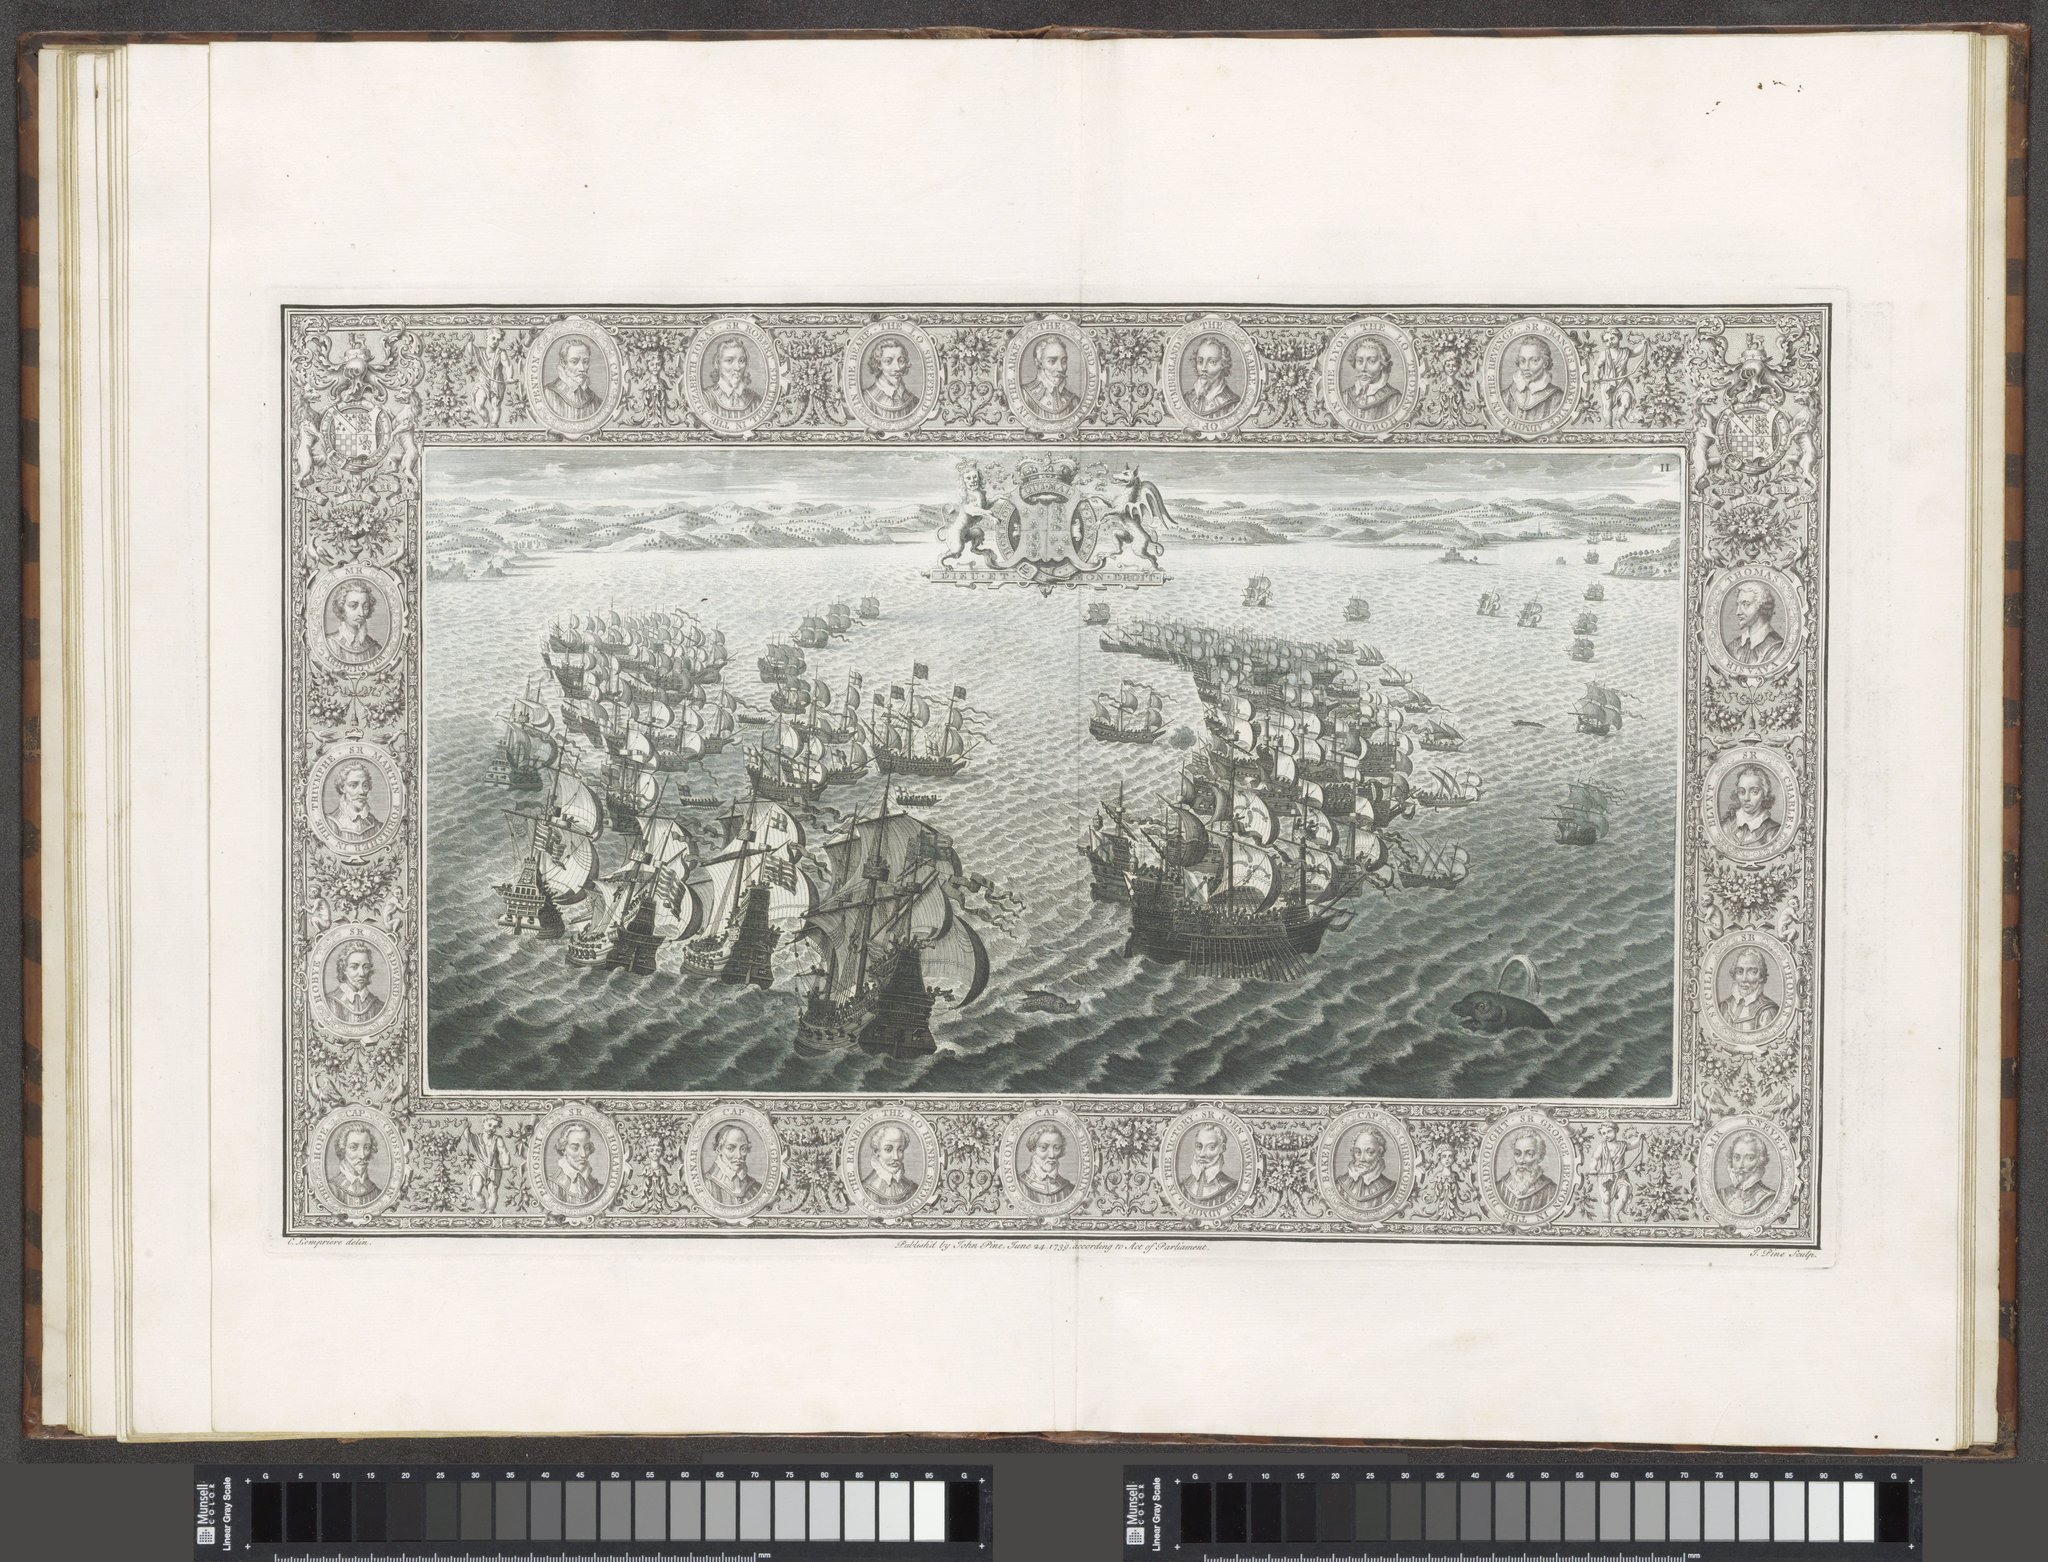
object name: album leaf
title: Reproductie van een wandtapijt over de Spaanse Armada (20-21 juli)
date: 1739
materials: paper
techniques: engraving, etching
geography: london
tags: plymouth, politician, coat of arms (as symbol of the state, etc.), monkeys, apes, birds, battle (+ naval force), tapestry, armorial bearing, heraldry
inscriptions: date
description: Reproductie van een wandtapijt gemaakt in opdracht van Charles Howard (1536-14 december 1624), Lord High Admiral. Het tapijt werd geweven door Francis Aertsz Spierincx in Delft, naar het karton van Hendrik Cornelisz Vroom. Vroom gebruikte als leidraad voor zijn ontwerp een getekende kaart van Robert Adams uit 1588 of de prent die daarvan twee jaar later werd gemaakt en uitgegeven door Augustine Ryther. Deze reproductie werd volgens de tekst van de prent gegraveerd door John Pine naar de tekening die Clement Lemprière van het tapijt maakte. Het tapijt zelf ging in 1834 bij een brand verloren.